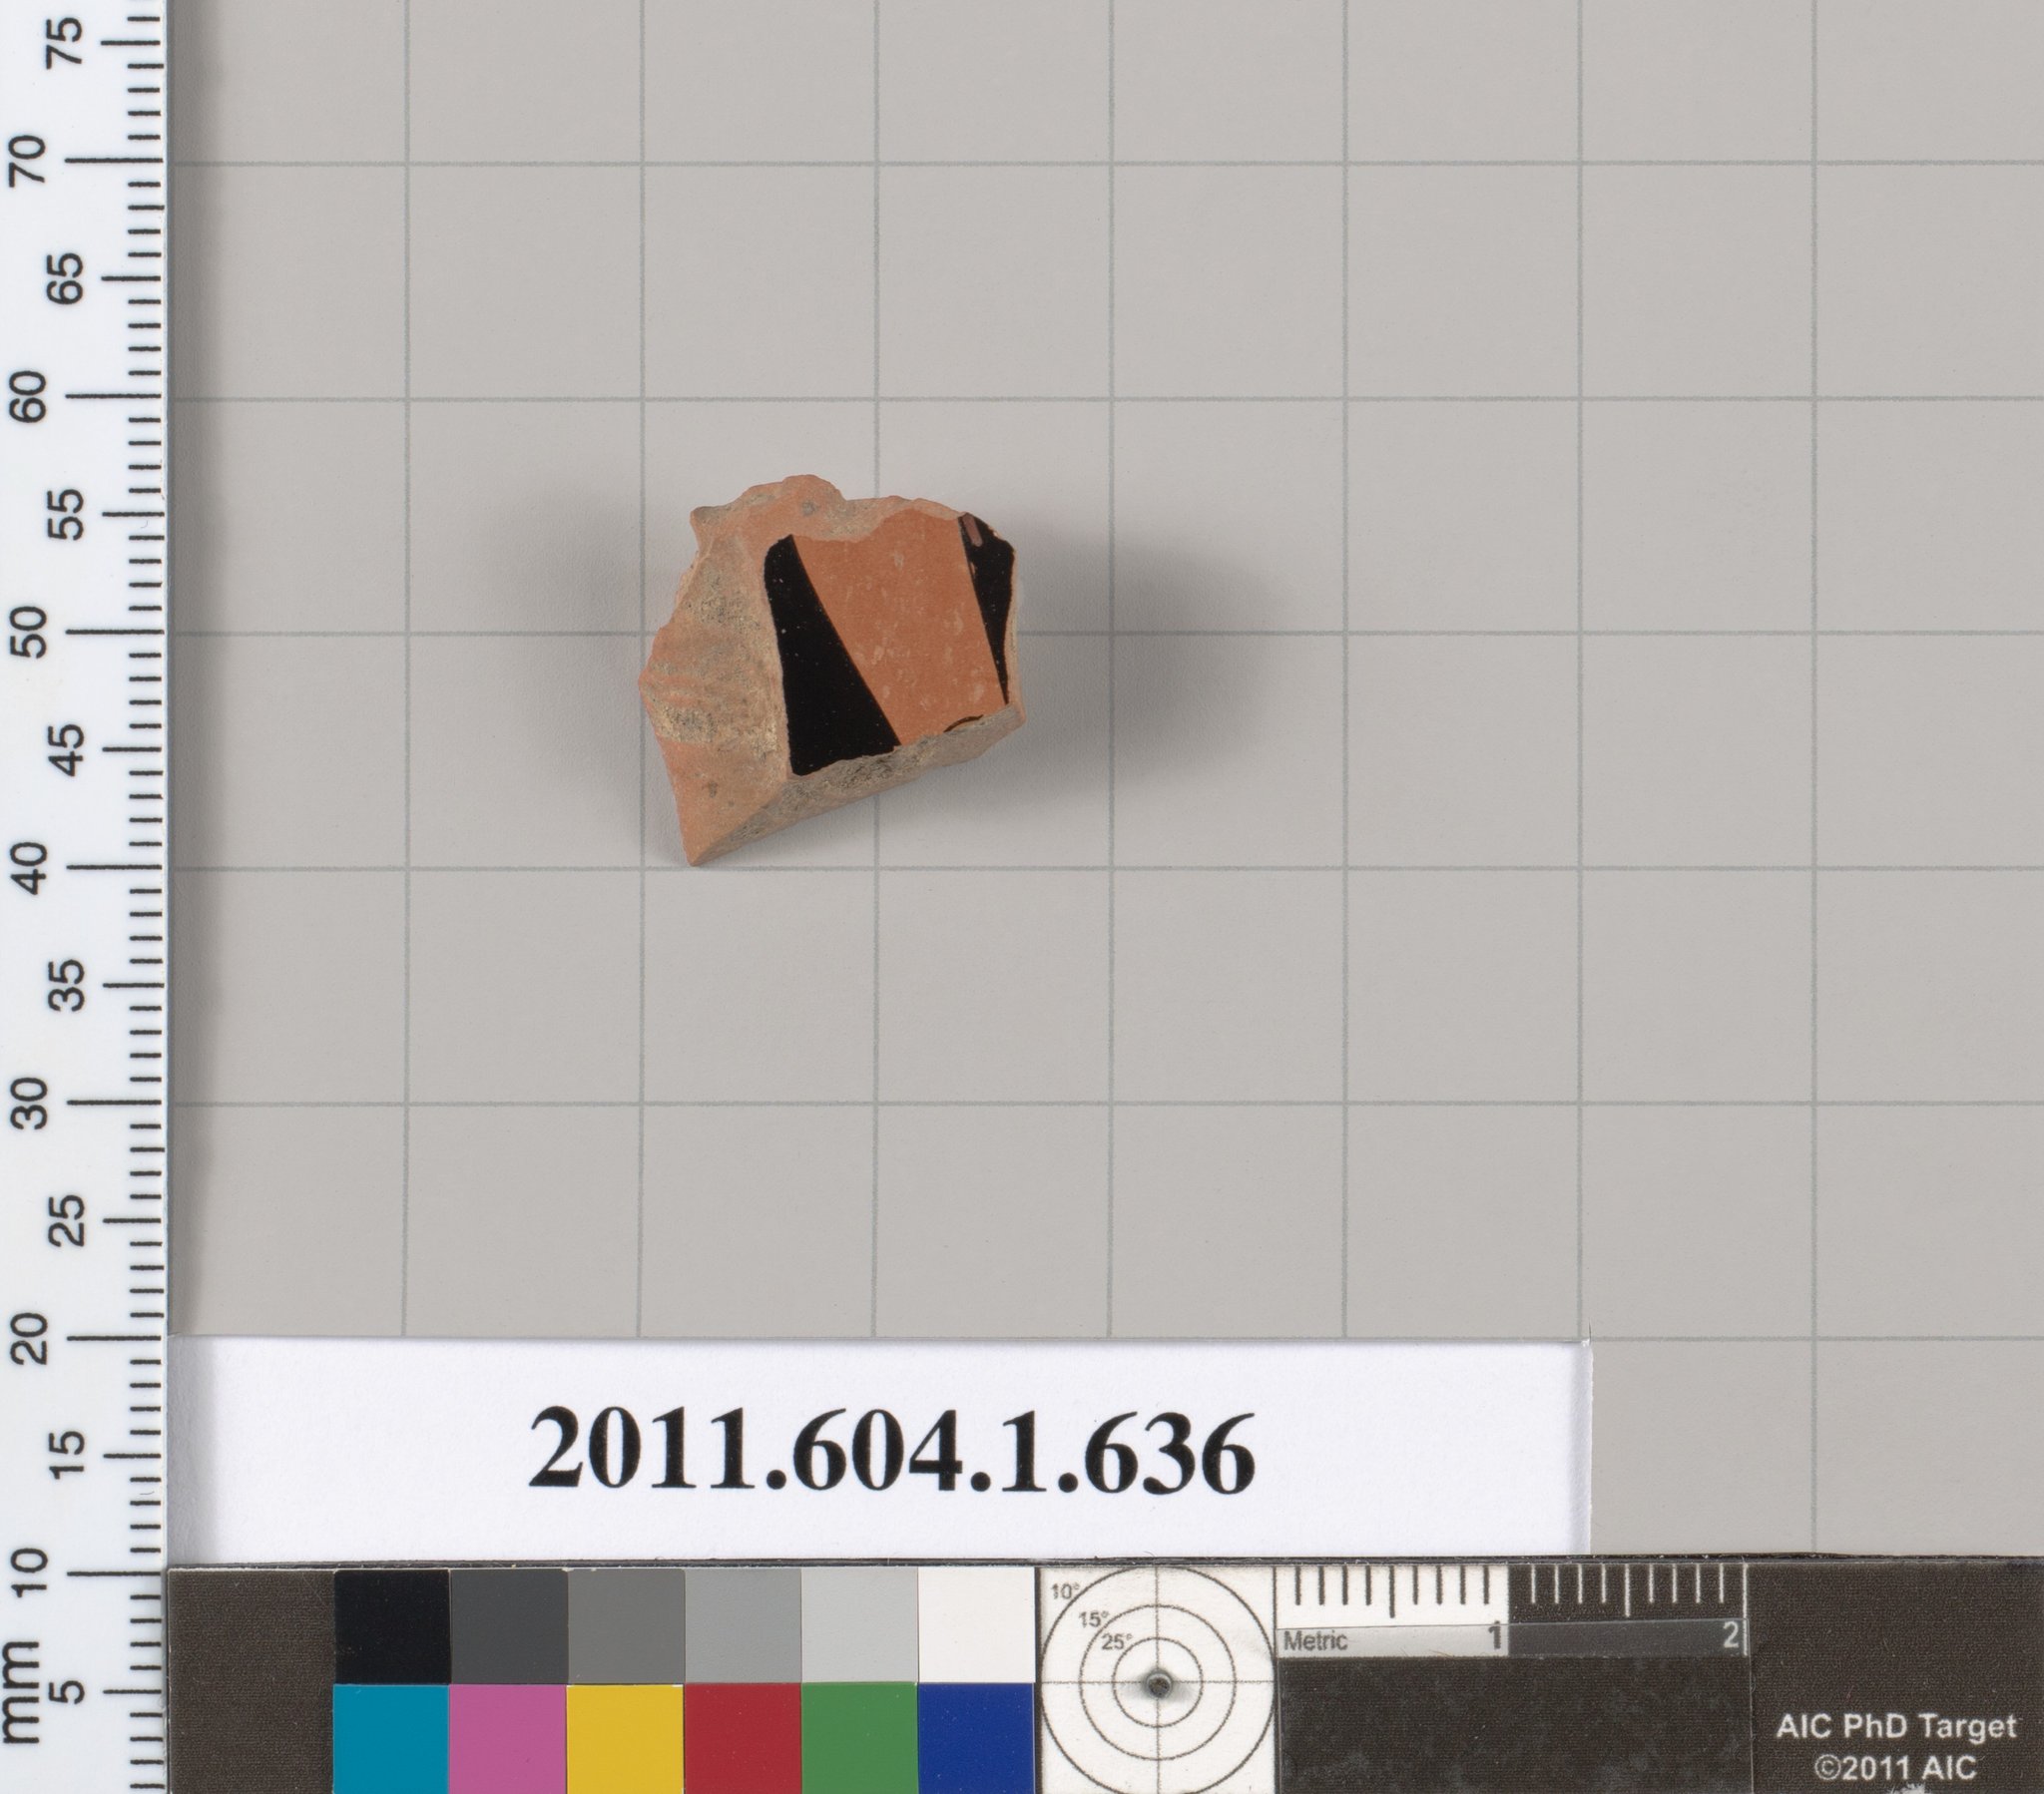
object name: kylix fragment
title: Terracotta fragment of a kylix (drinking cup)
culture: greek, attic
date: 475-451 BCE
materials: terracotta